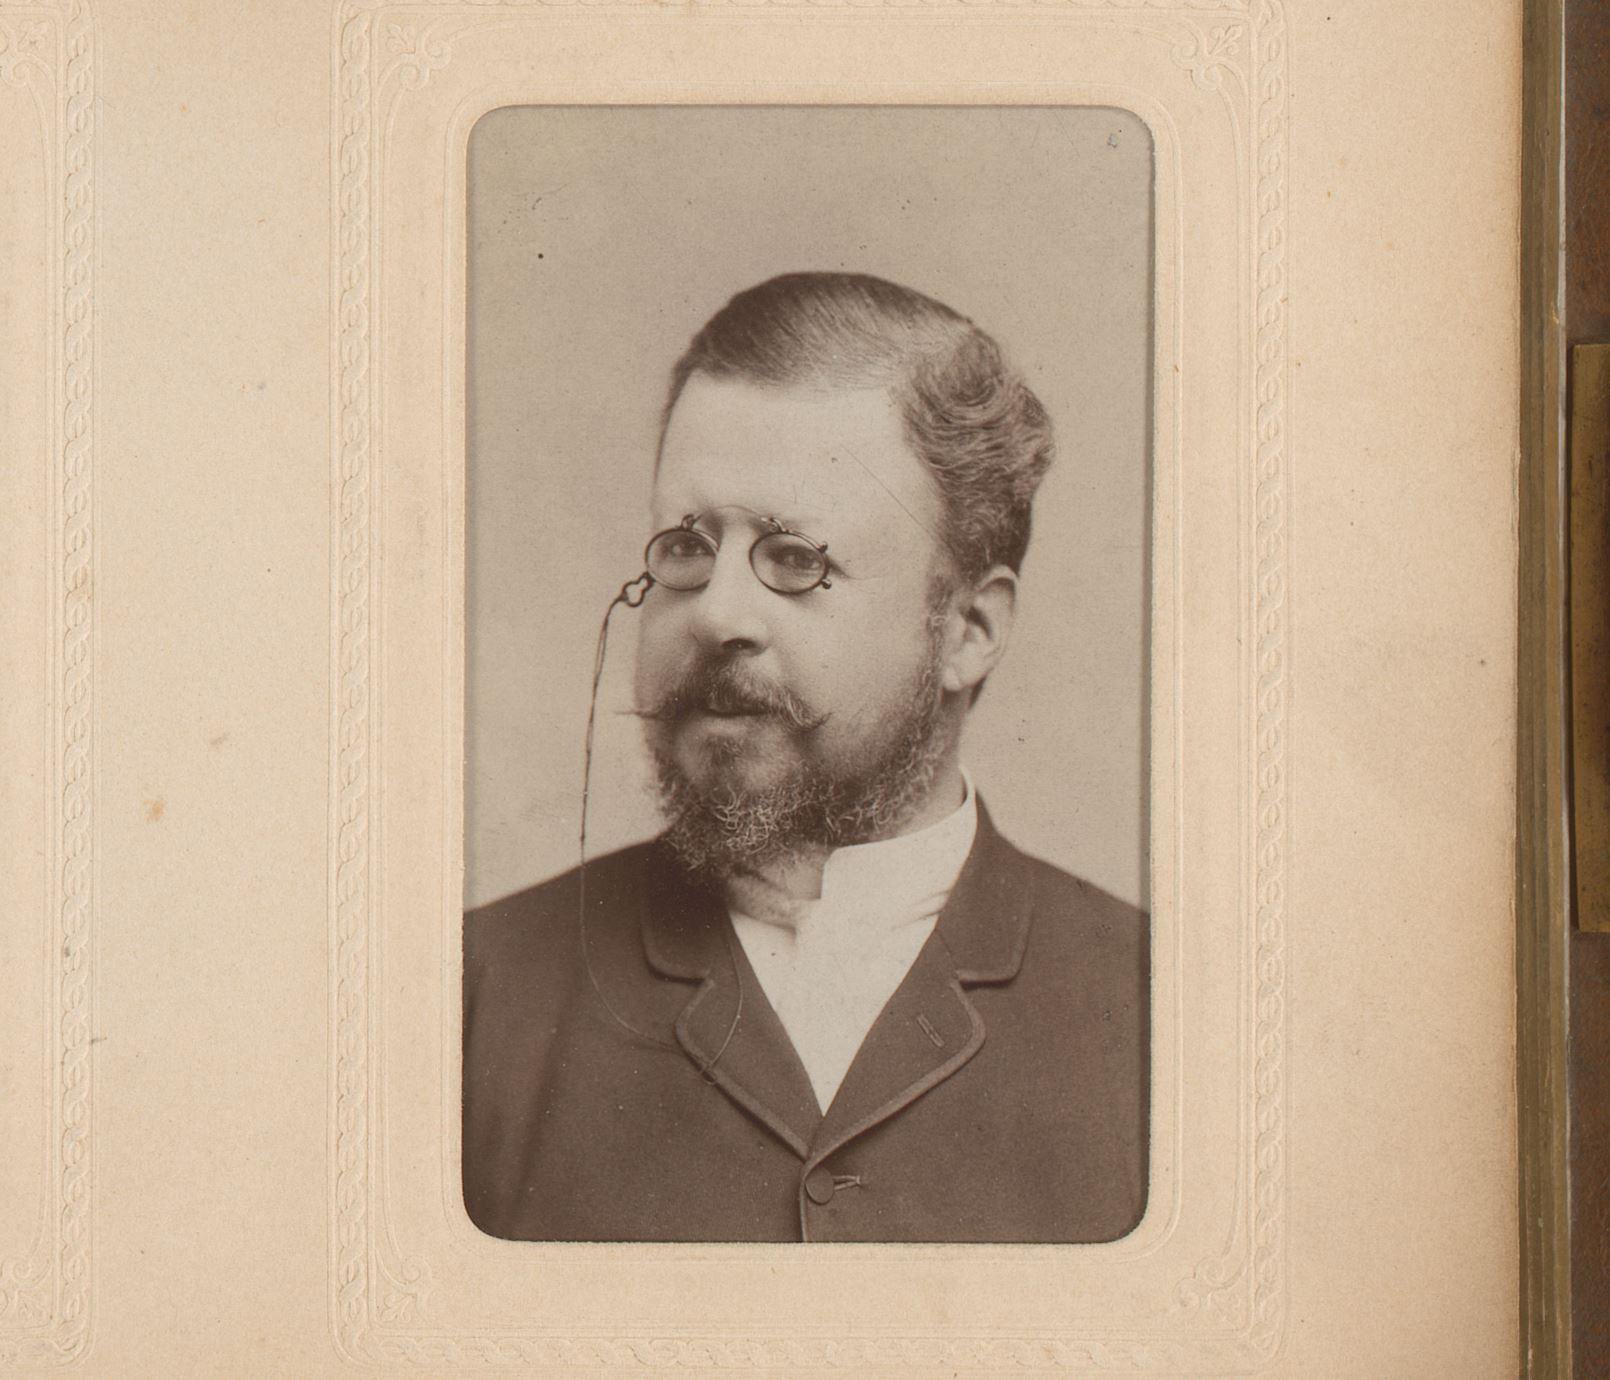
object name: album leaf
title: Portret van een man met bril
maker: heinrich eckert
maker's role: fotograaf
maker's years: 1833-1905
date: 1863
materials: cardboard, photographic support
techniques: albumen print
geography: prague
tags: eyeglasses, spectacles, historical persons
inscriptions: inscription: ‘H. ECKERT/ CÆS. REG. AULÆ ET CAMERÆ PHOTOGR./ PRAGÆ./ Multiplicatio reservata’, name: ‘K[..]e [.]obrovi[.]’, name: ‘A. Likes’